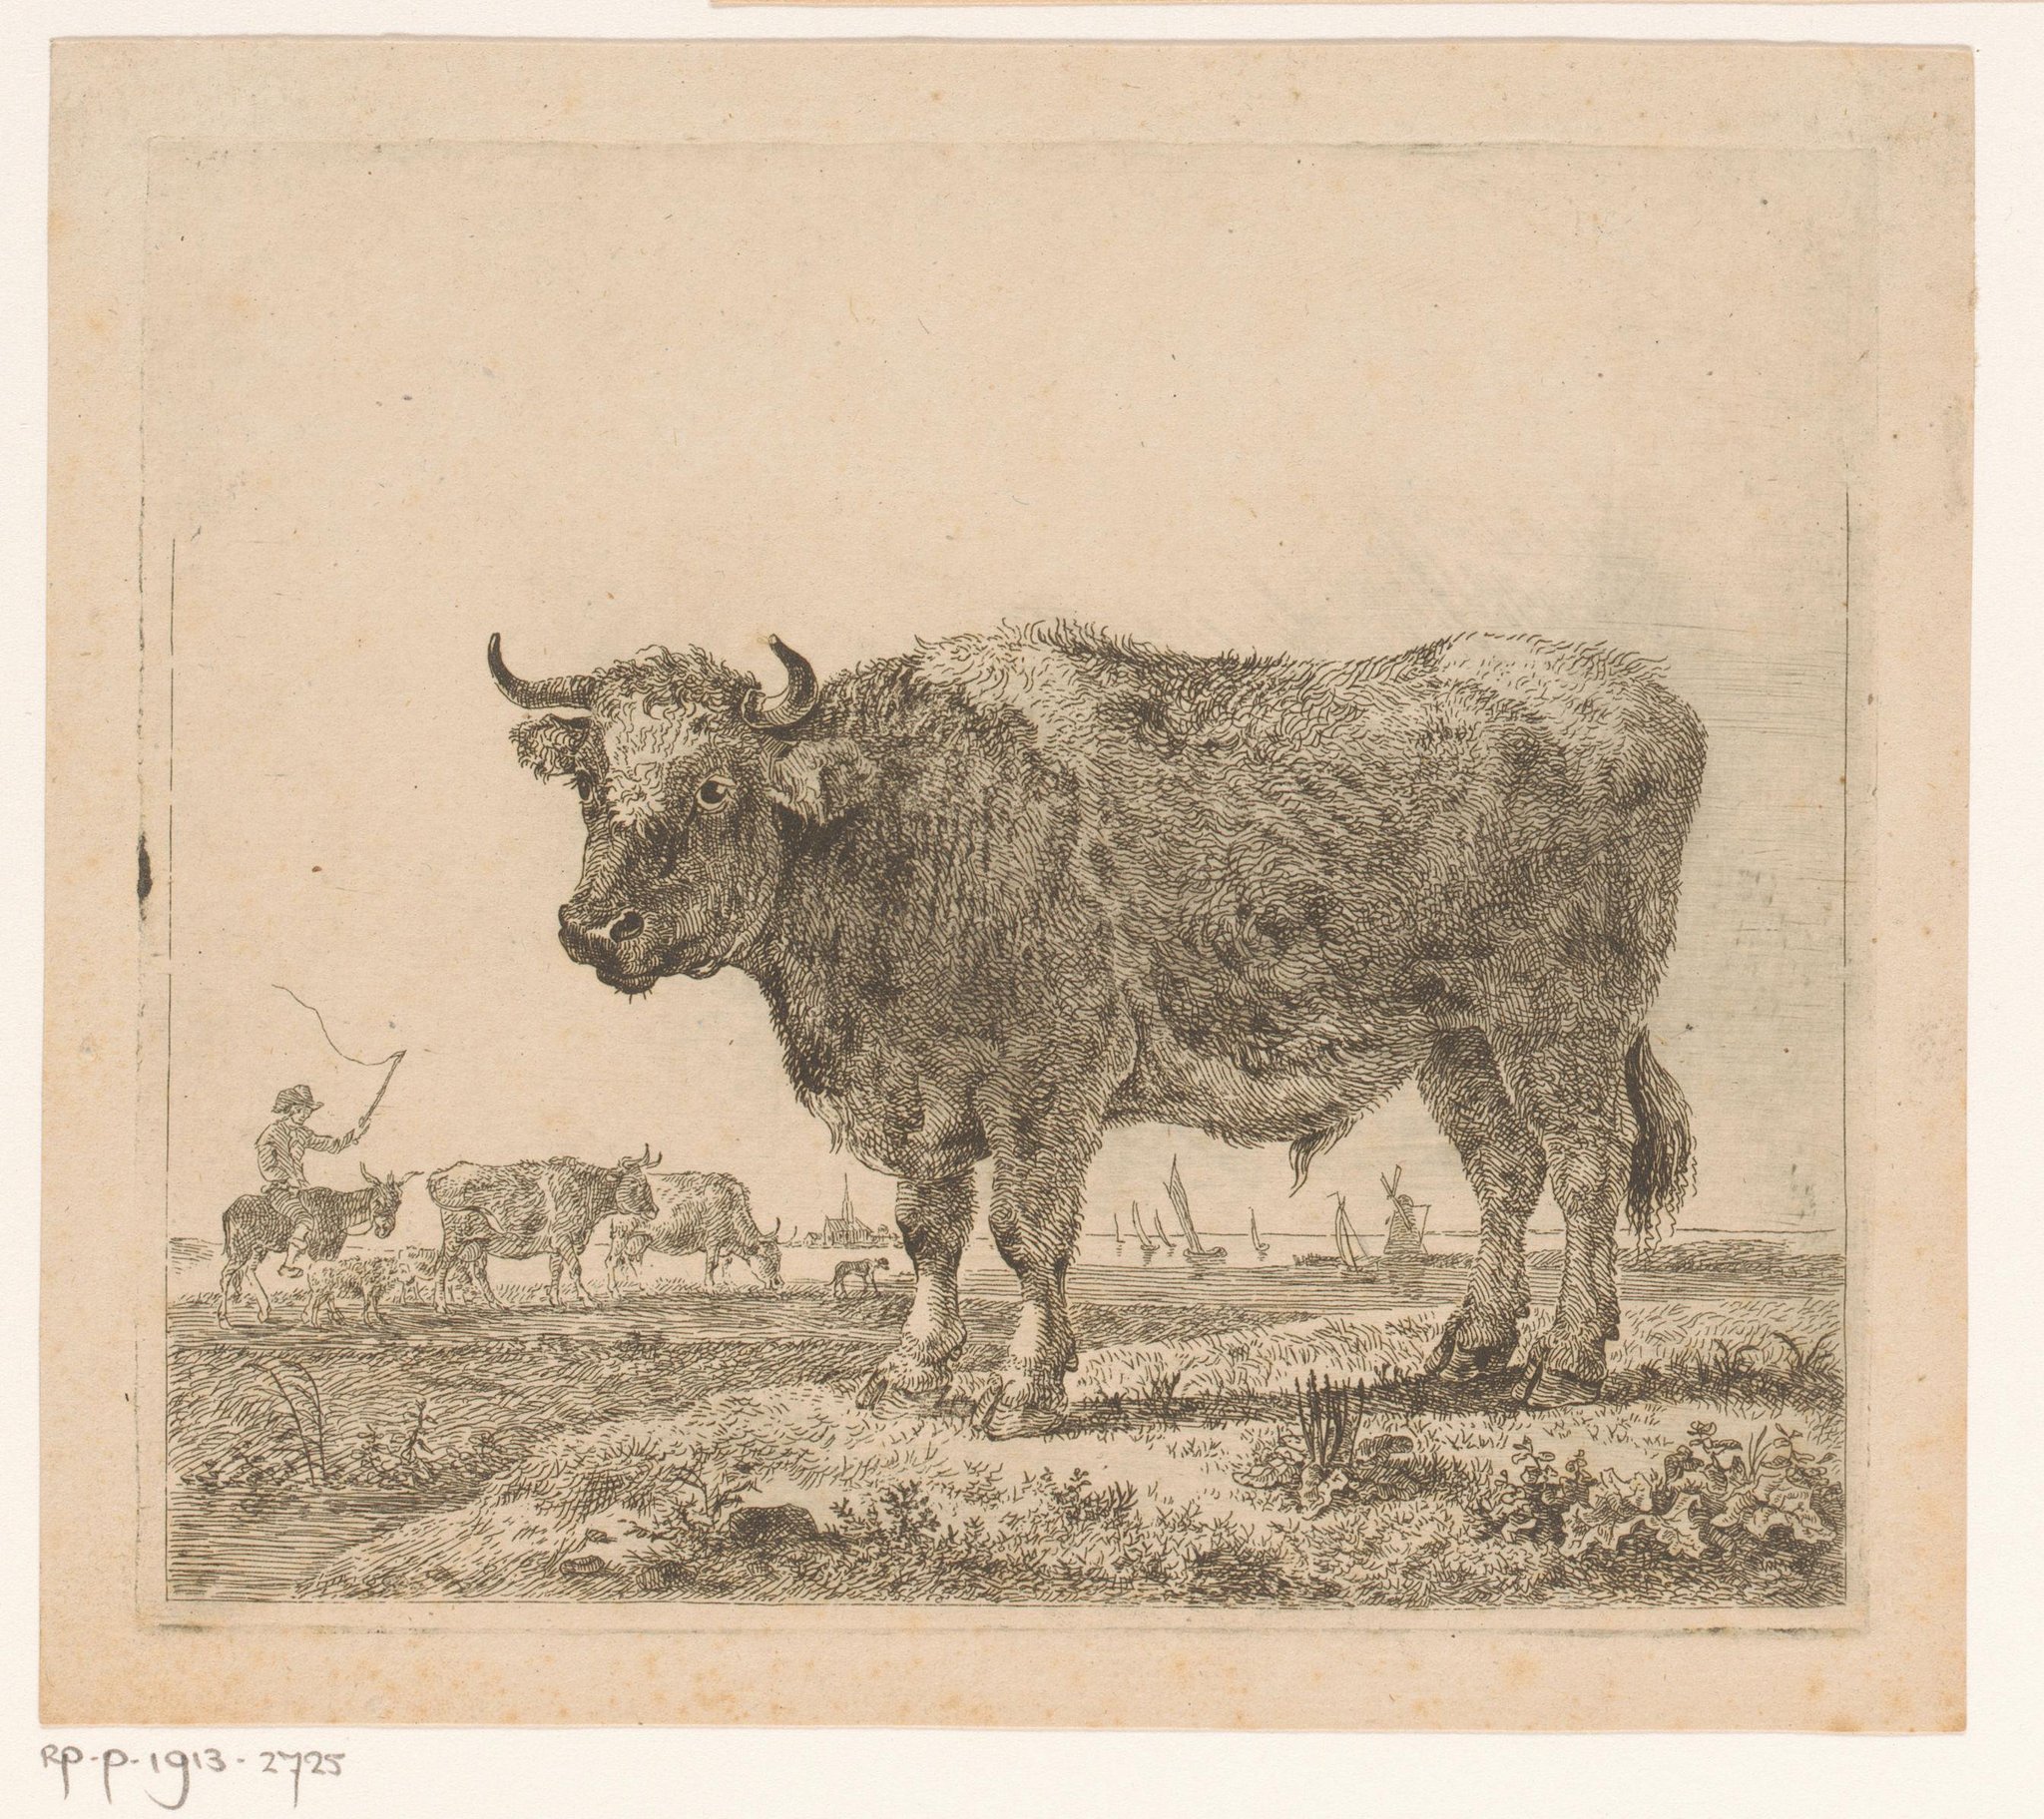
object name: print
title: Landschap met os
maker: jean baptiste de roy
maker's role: print maker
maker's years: 1759-1839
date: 1769-1839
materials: paper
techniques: etching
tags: cow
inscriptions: collector's mark: Lugt 1485